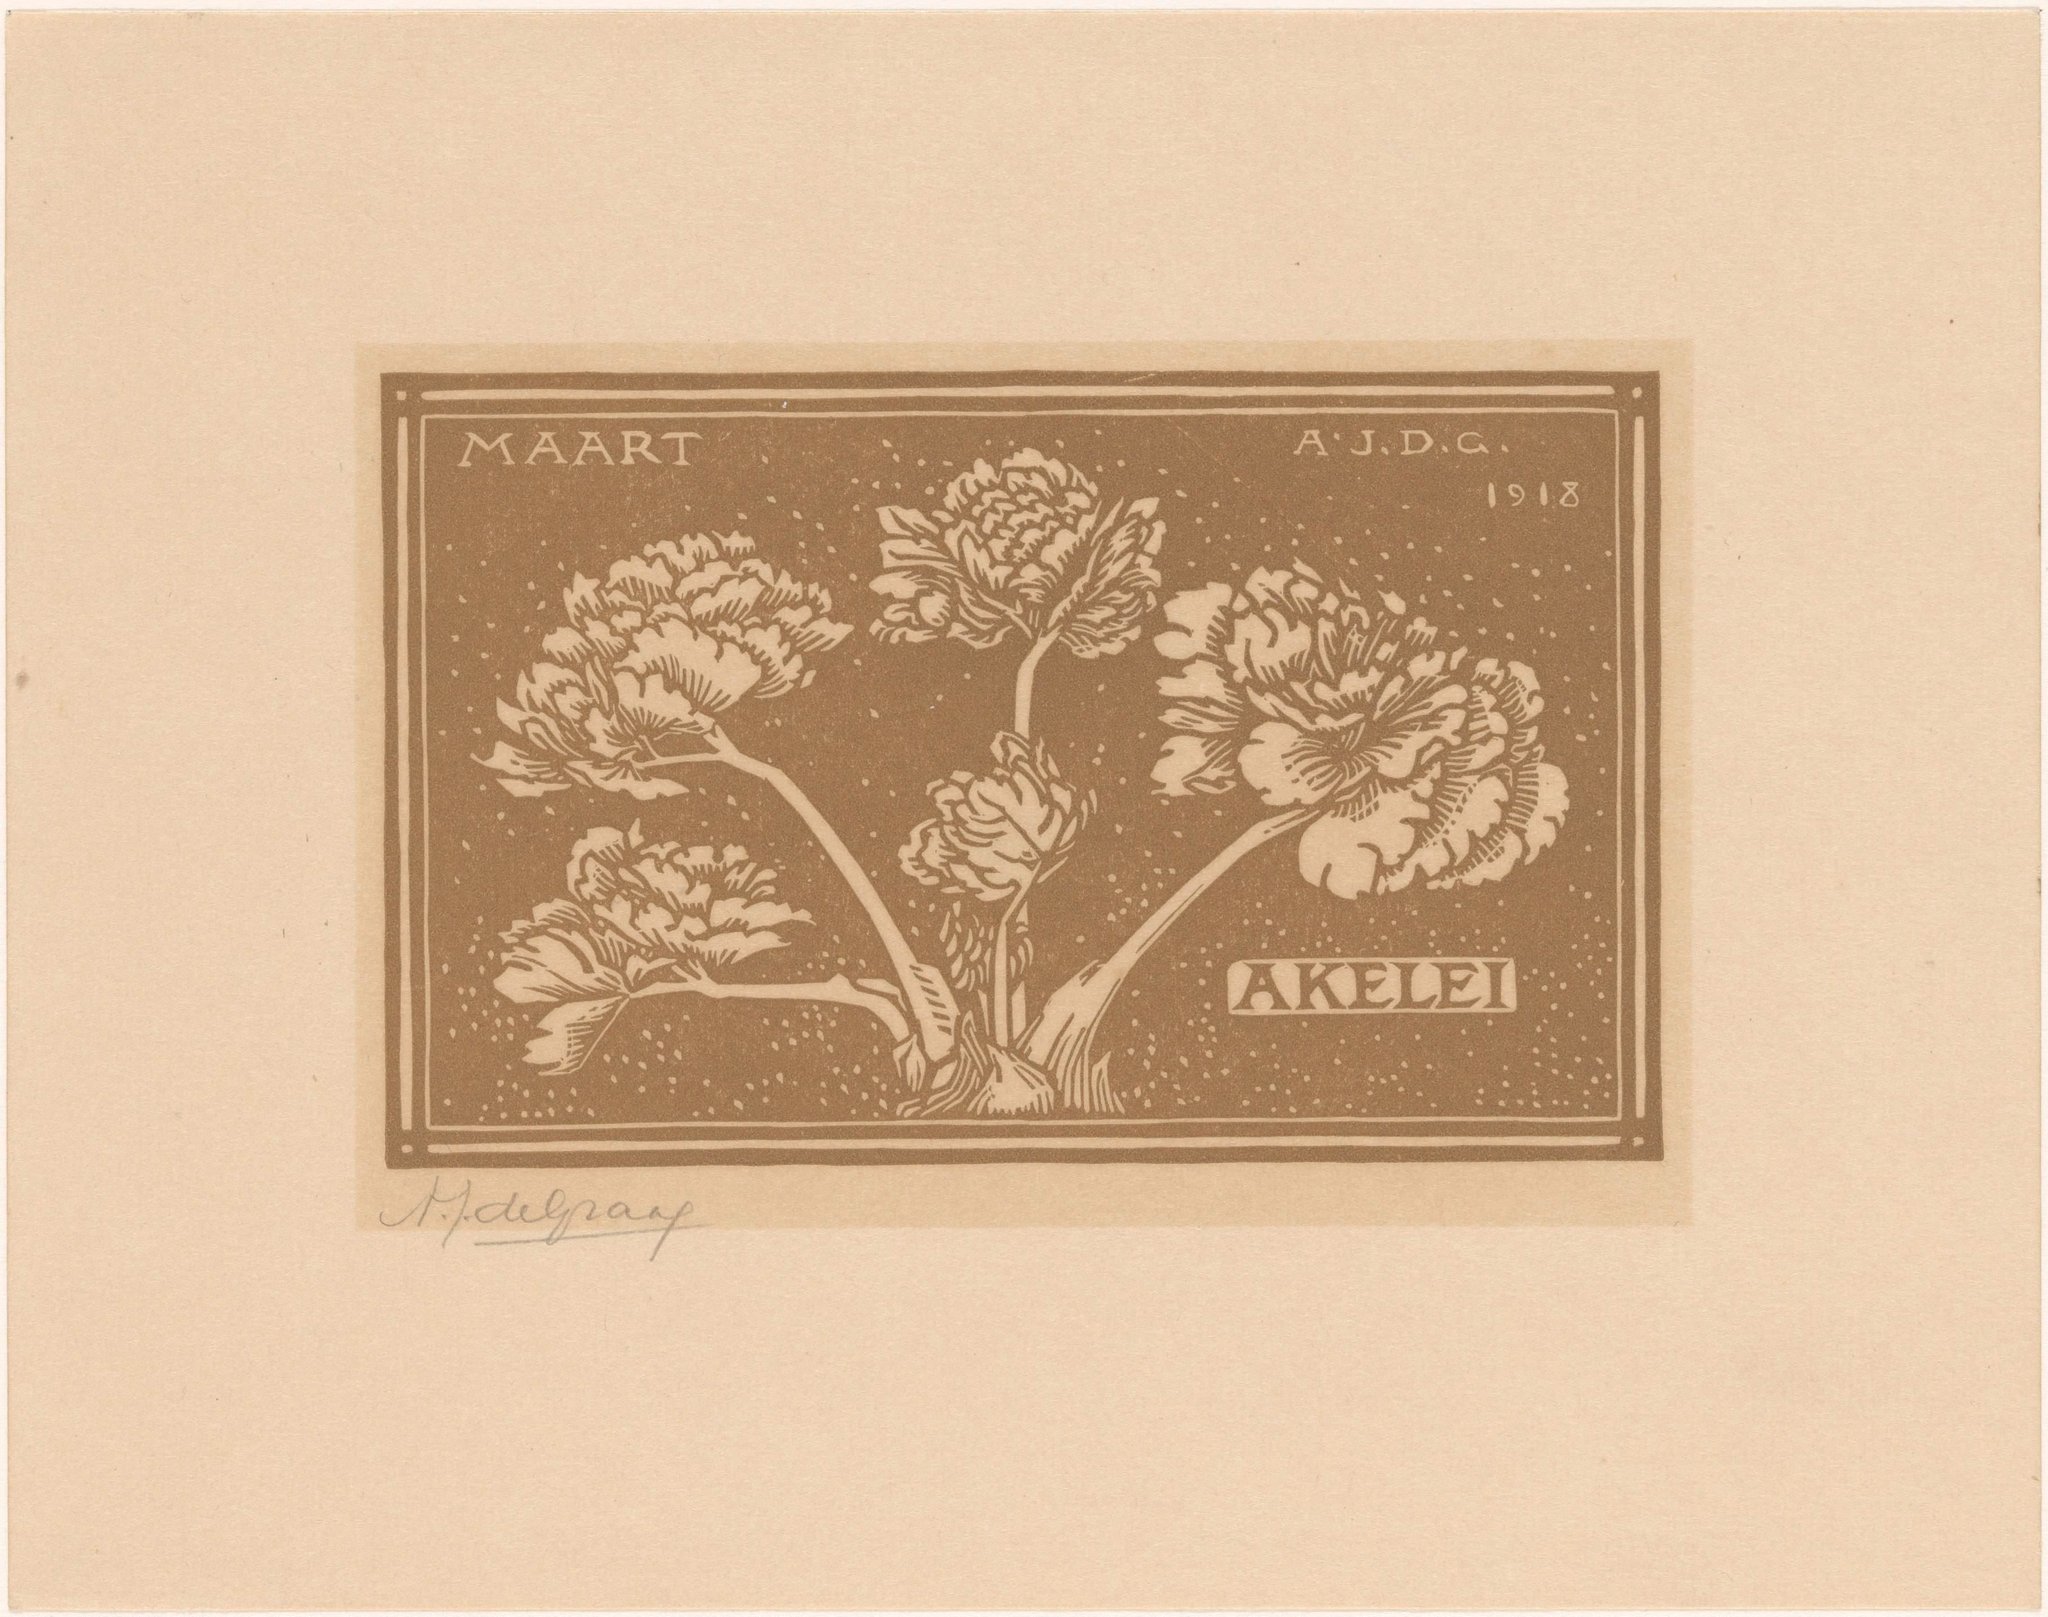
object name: print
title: Maart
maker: julie de graag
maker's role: draughtsman, print maker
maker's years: 1877-1924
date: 1918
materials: paper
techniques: woodcut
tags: march; 'marzo' (ripa), flowers: columbine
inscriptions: collector's mark: Lugt 2228